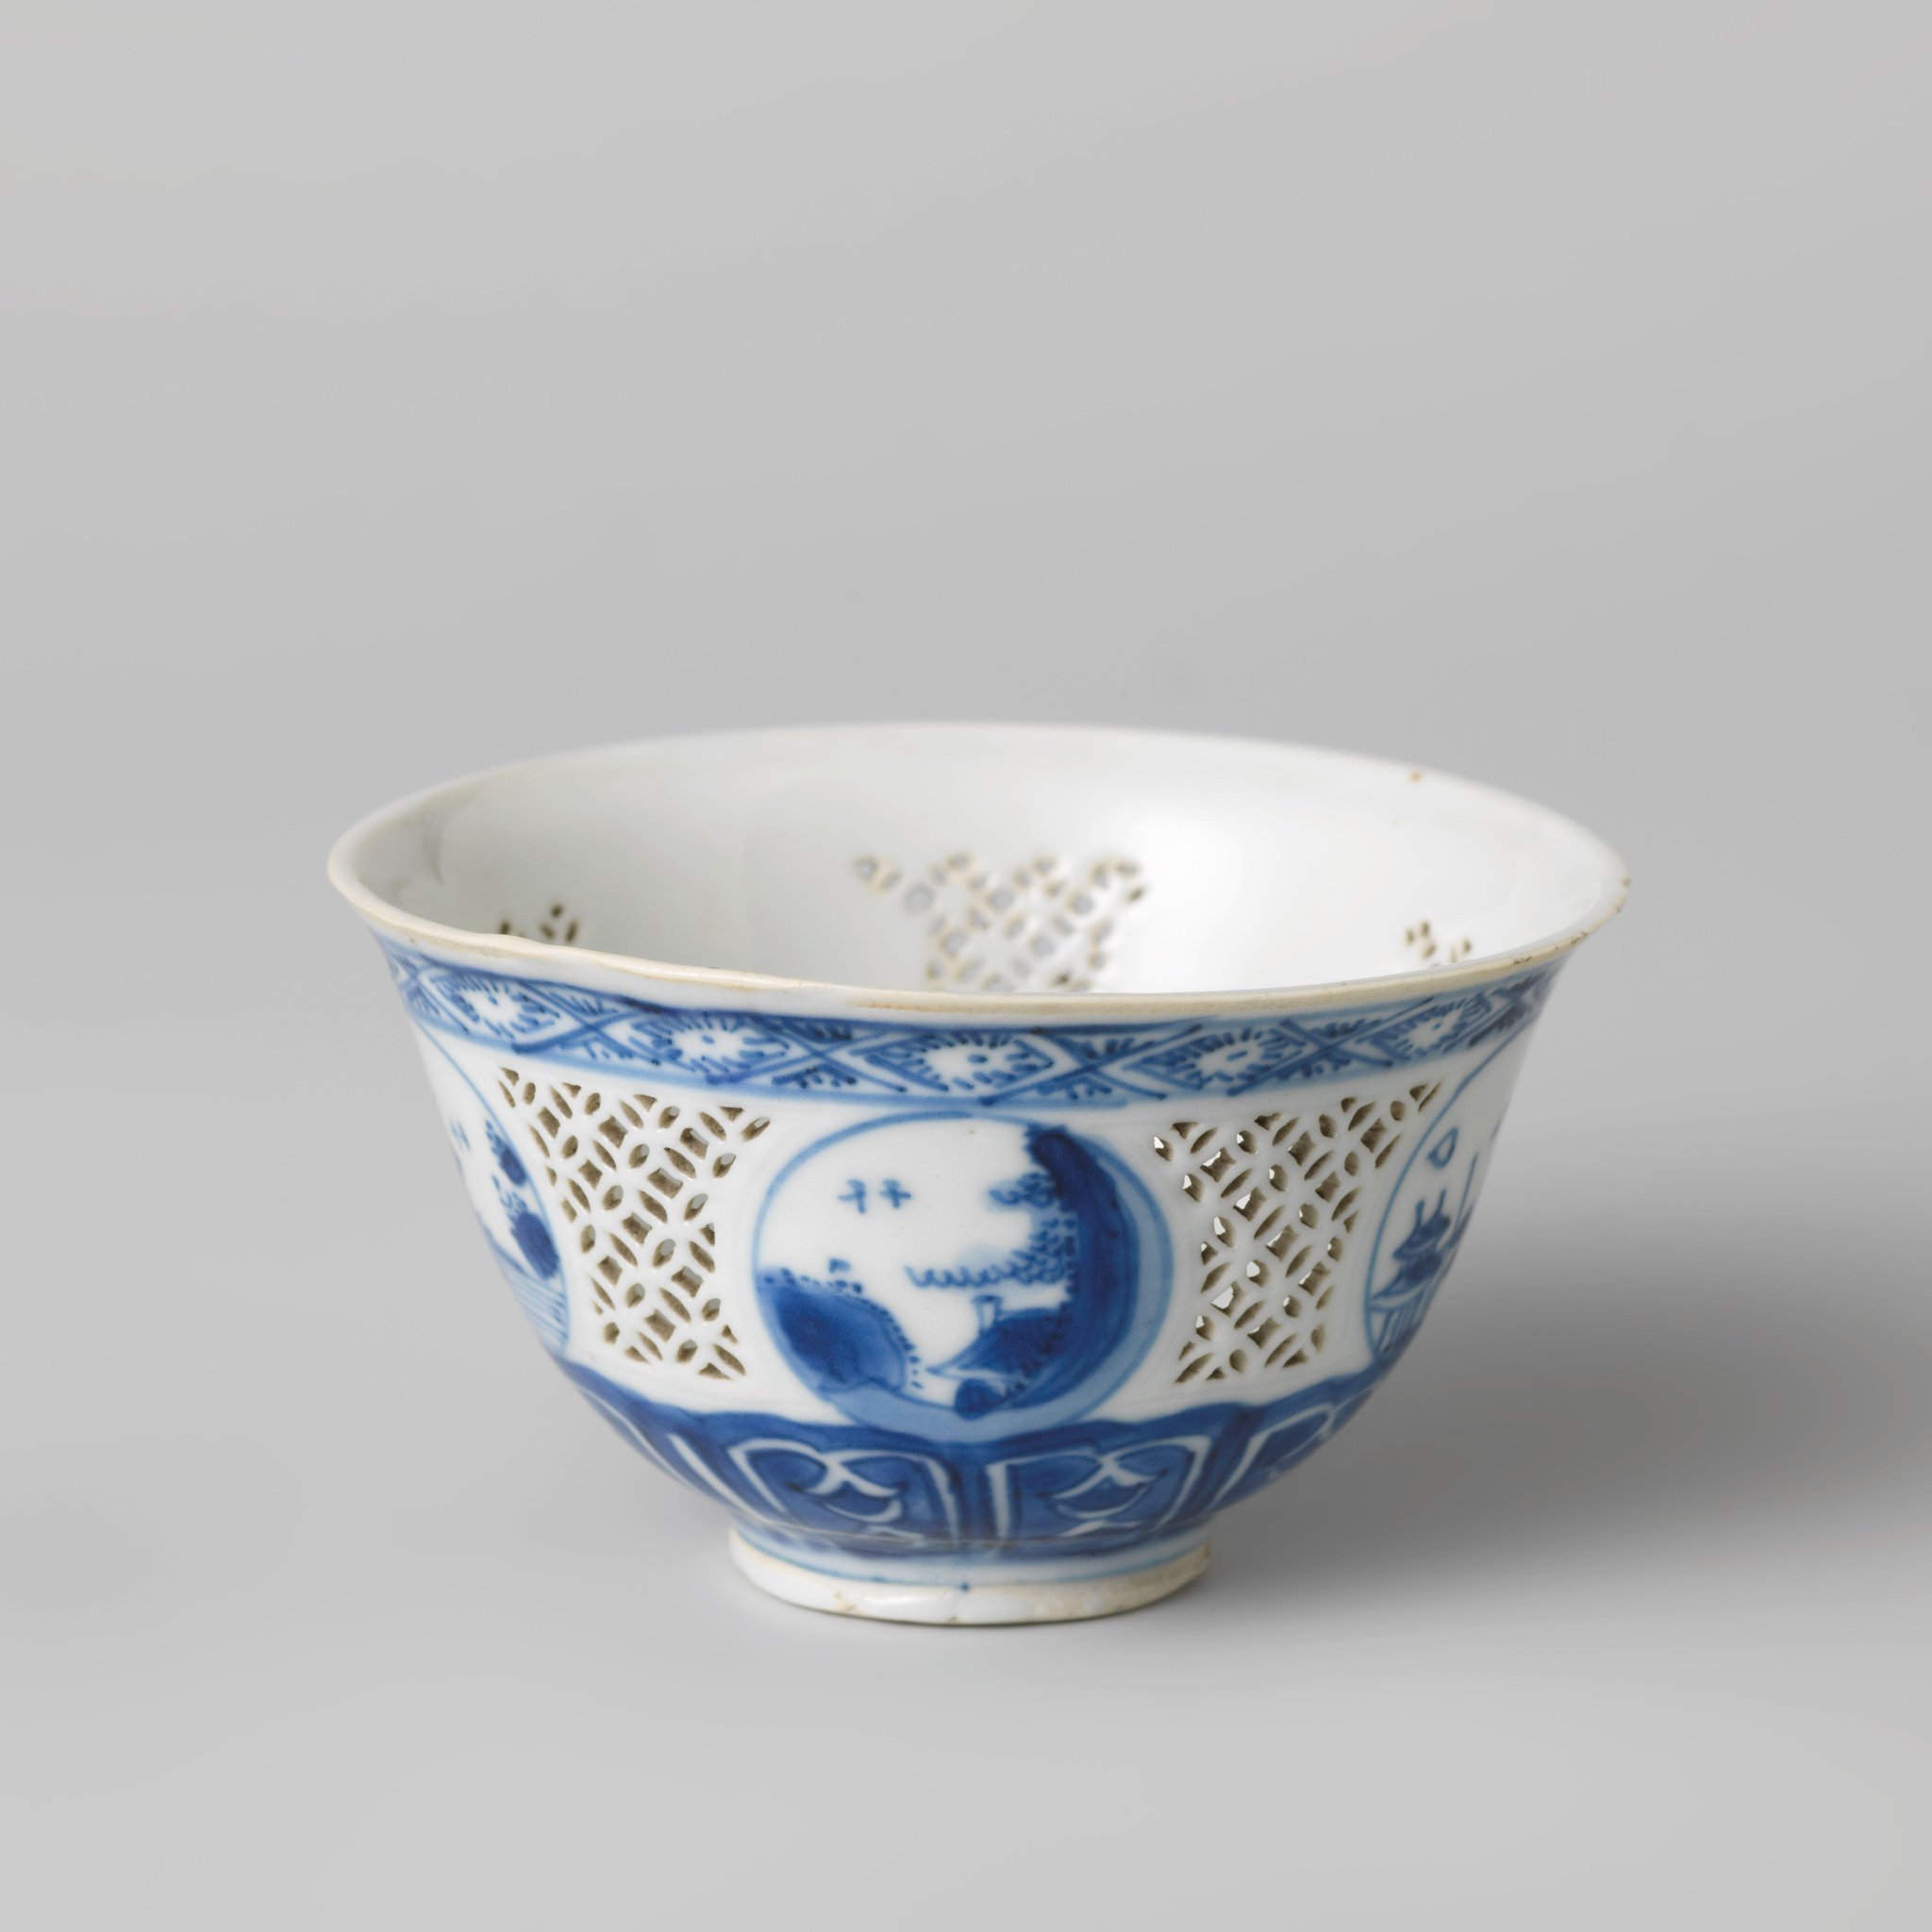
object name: cup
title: Bell-shaped bowl with pierced sides and water landscapes in medallions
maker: Anonymous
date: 1635-1650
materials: cobalt, glaze, paint, porcelain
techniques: embroidery, firing, turning, vitrification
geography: china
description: Klokvormige kom van porselein, beschilderd in onderglazuur blauw. De wand van de kom is opengewerkt met daarin uitgespaard medaillons. In de medaillons rivierlandschappen met bomen, bergen en paviljoens; één medaillon met een plant bij een rots. De onderzijde van de wand met een band gestileerde bladmotieven. Op de buitenrand een band met servetwerk. De onderzijde en de buitenrand zijn ongeglazuurd. Enkele chips in de rand. Overgangsporselein in blauw-wit.